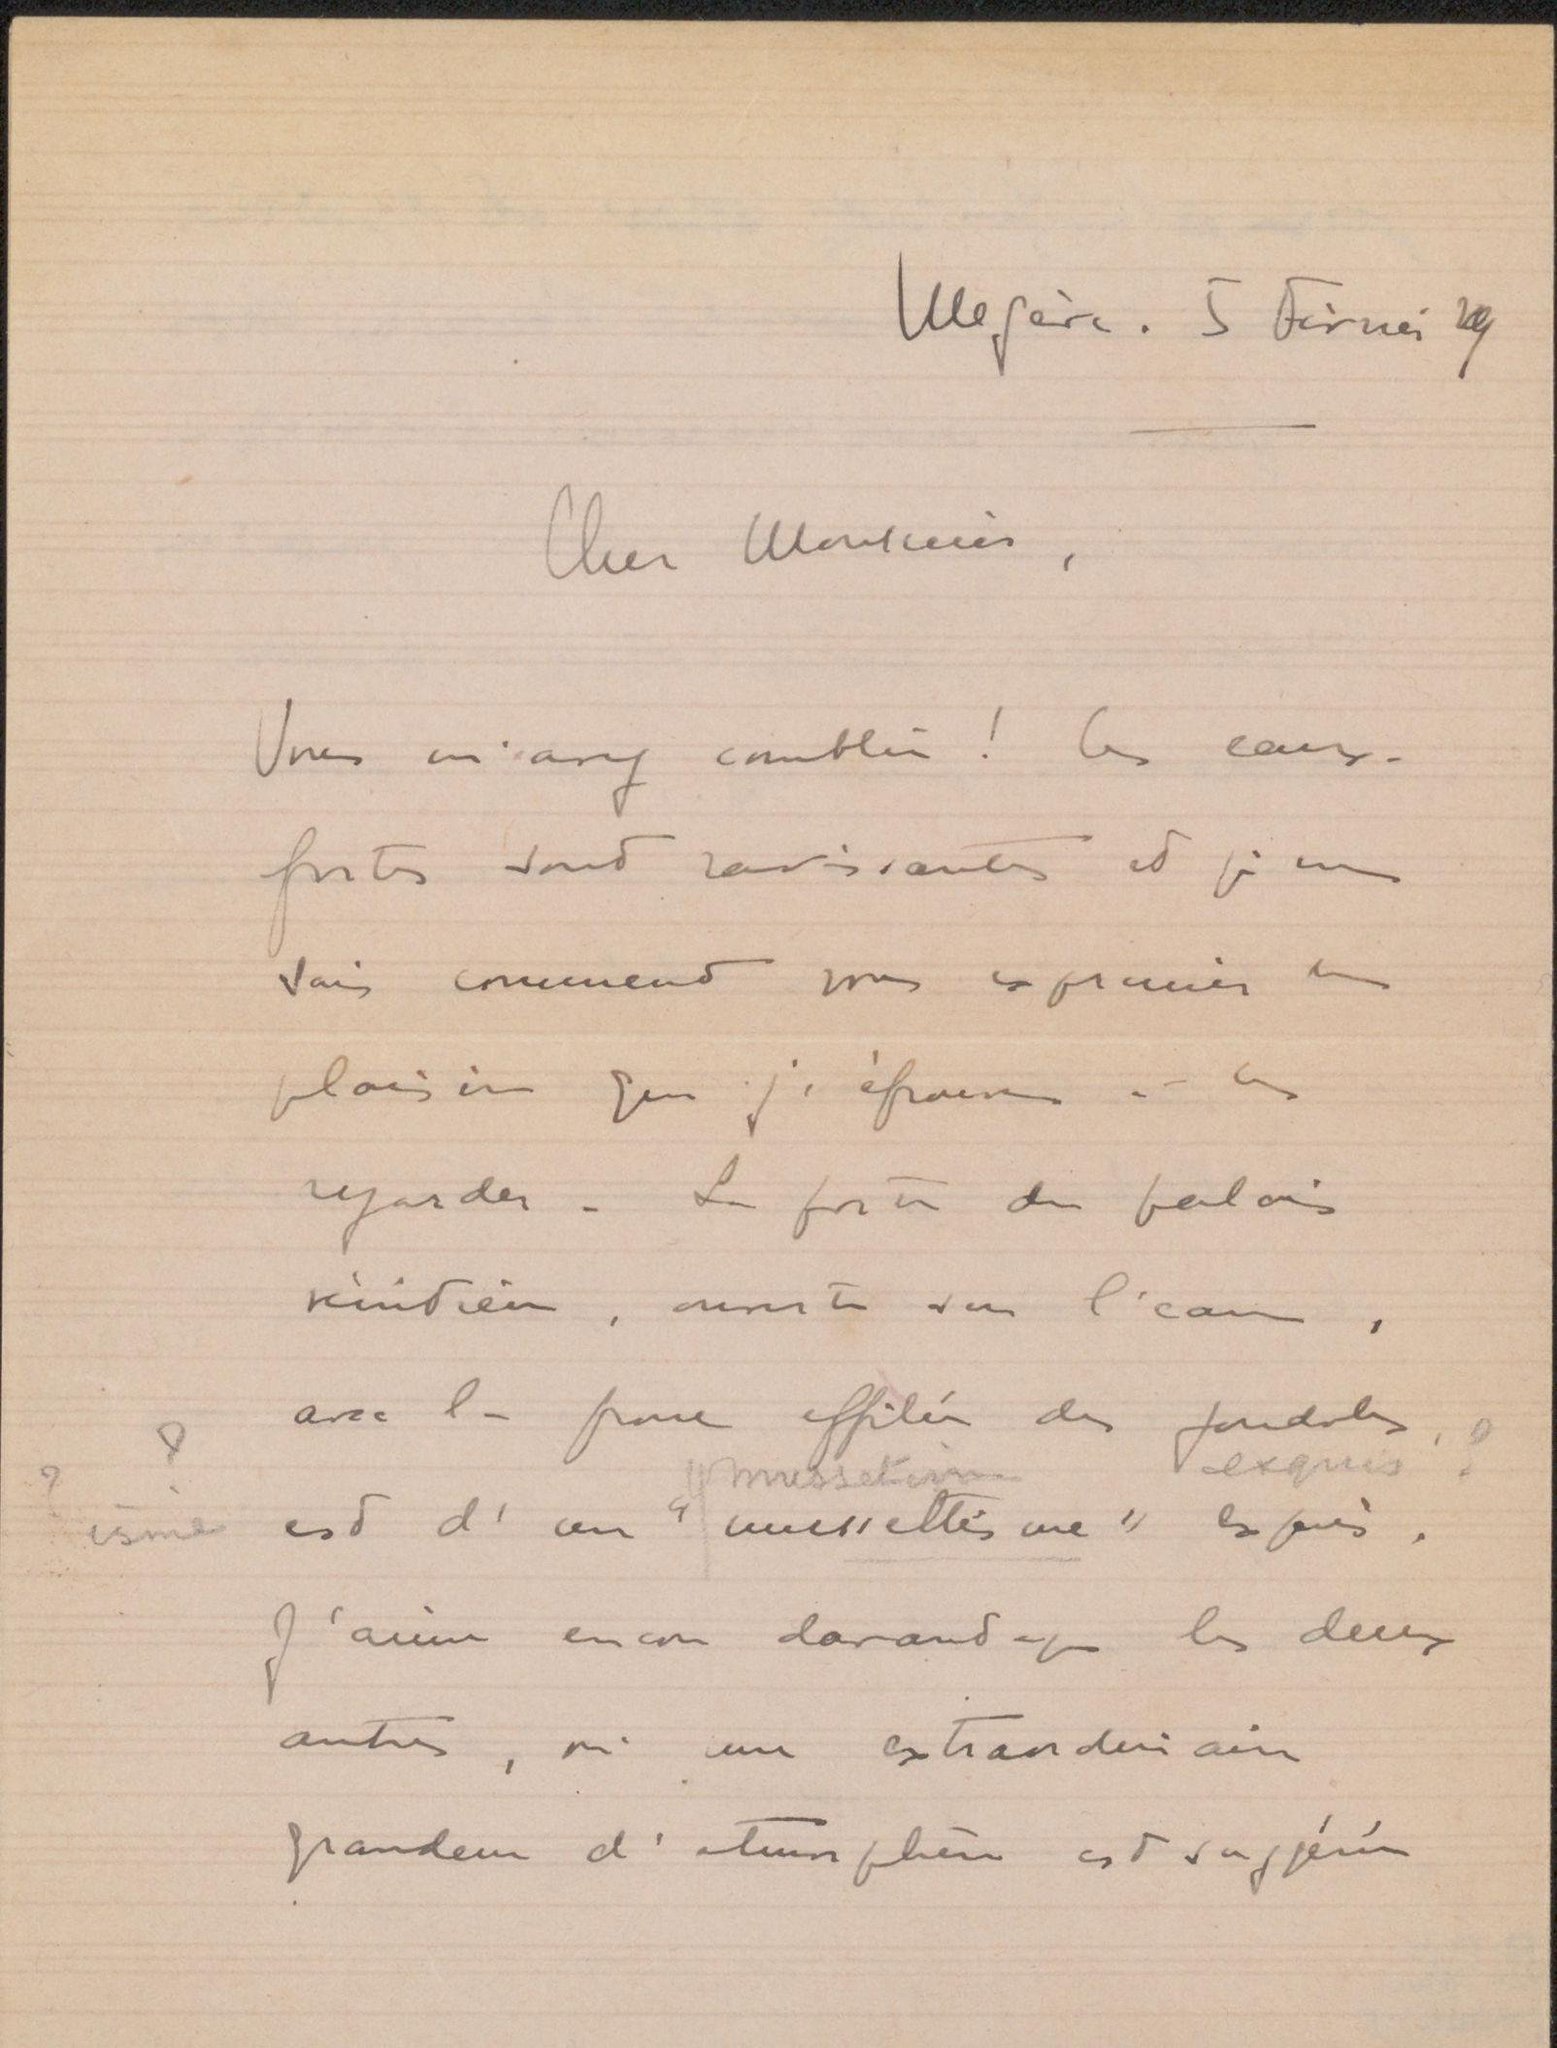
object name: letter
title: Brief aan Philip Zilcken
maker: simonne ratel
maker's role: schrijver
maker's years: 1900-1948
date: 1929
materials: ink, paper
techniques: pen, writing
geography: megève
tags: the hague, painter, draughtsman, philip zilcken, the graphic arts, paris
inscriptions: collector's mark: ‘RPK’